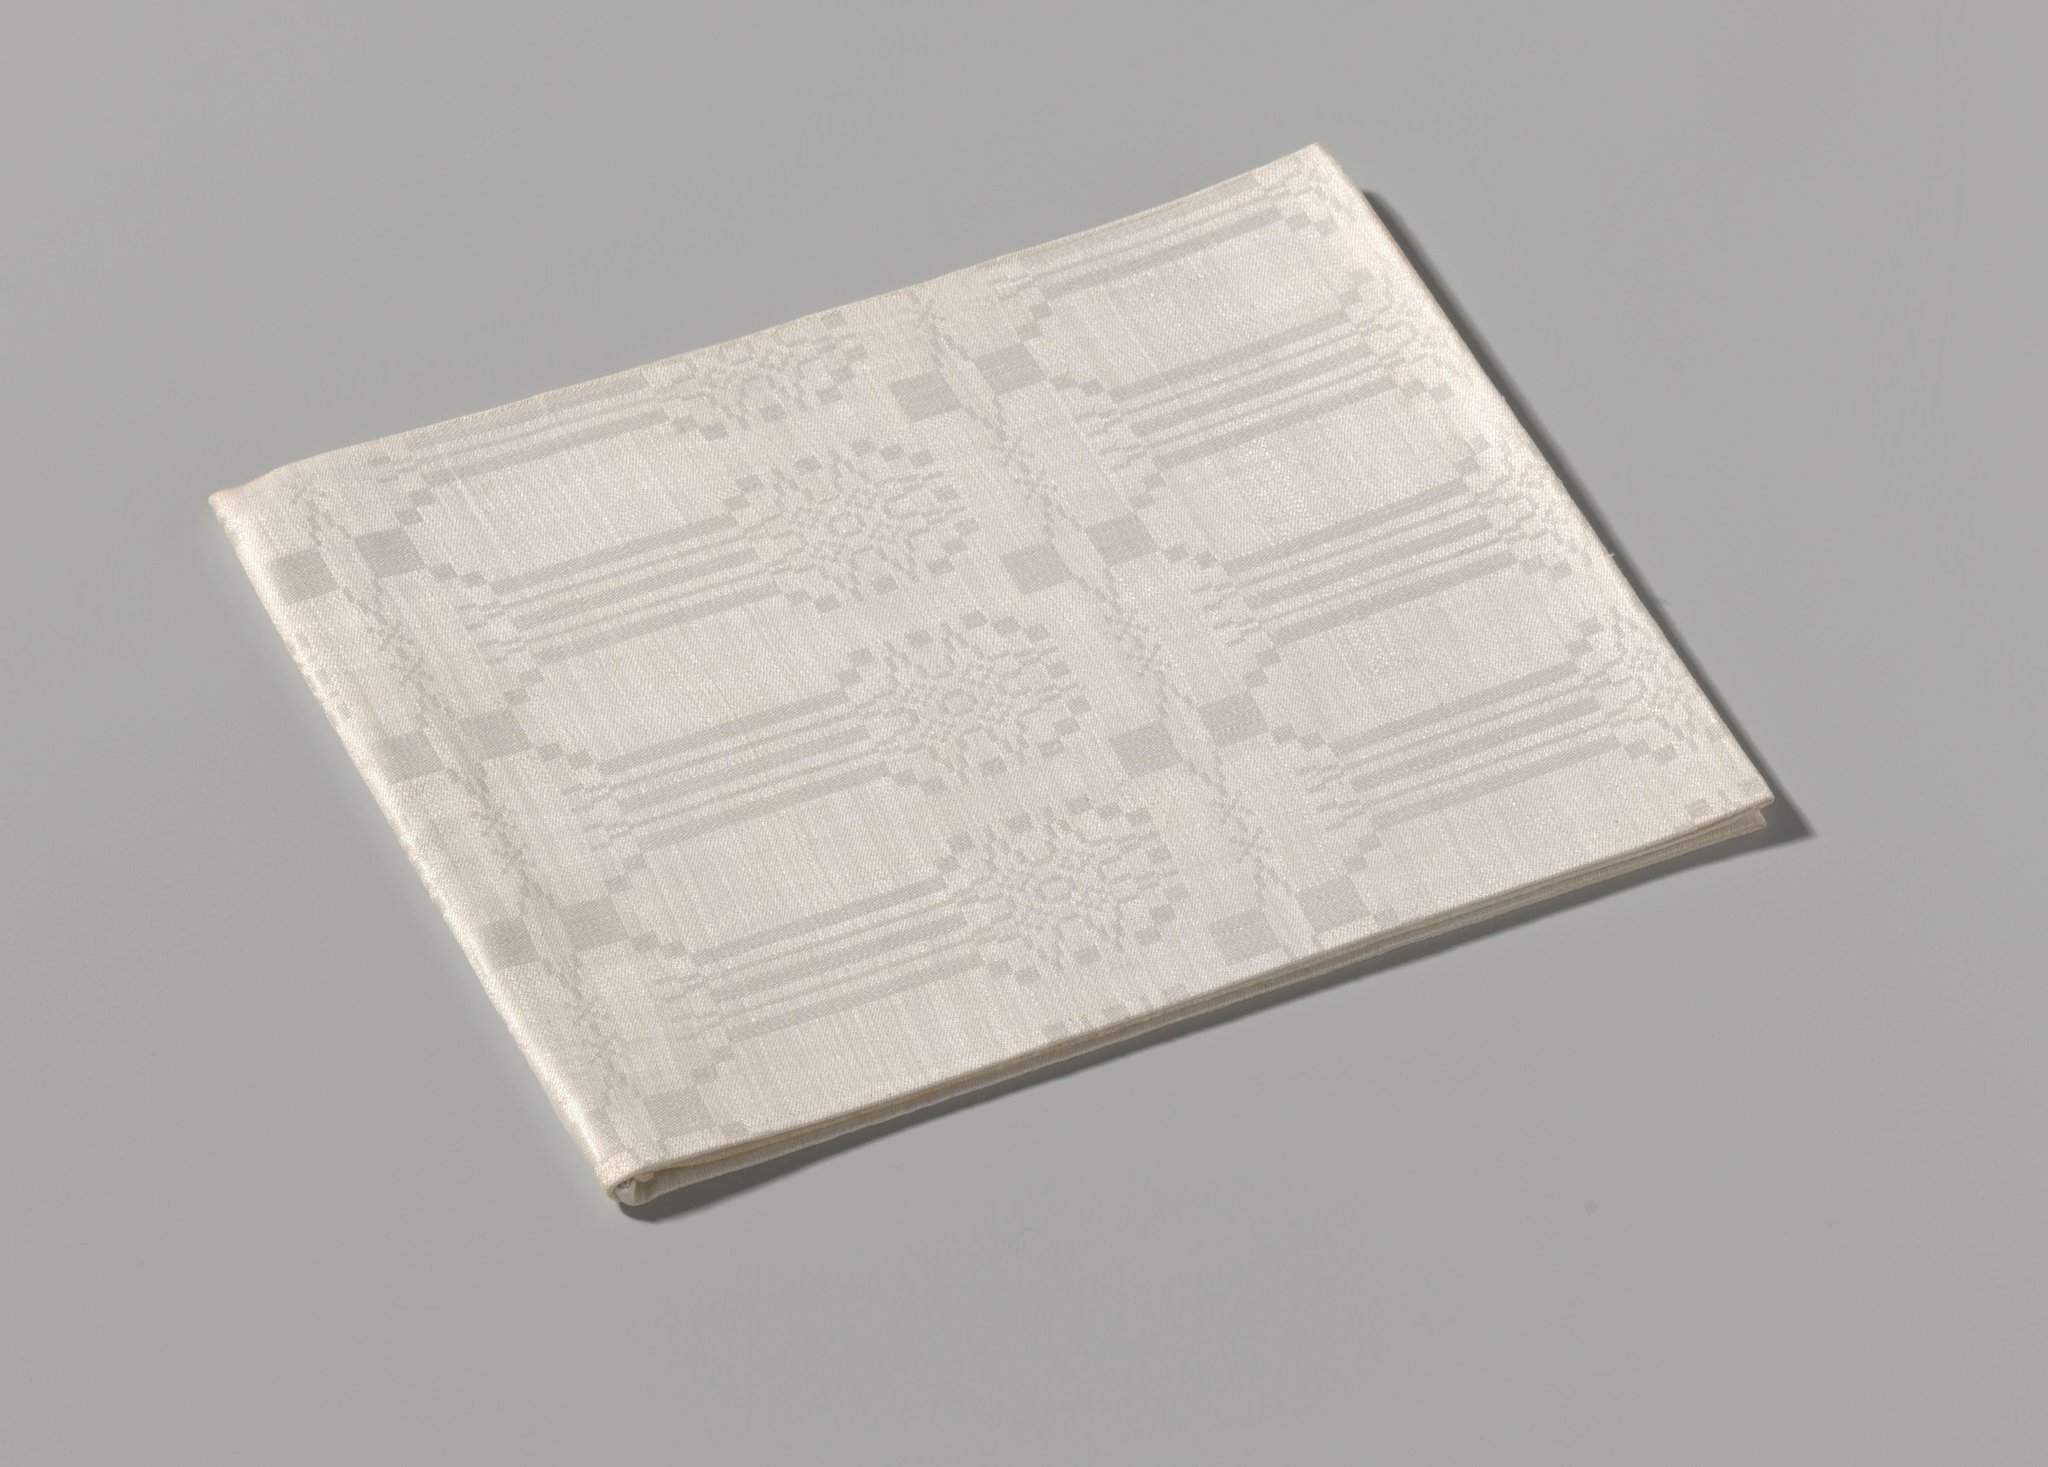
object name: napkin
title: Servet van linnen met pellenpatroon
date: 1734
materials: linen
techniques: peeled fabric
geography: northern netherlands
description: Servet van wit linnen met pellenpatroon "oranjeboom", merk WG 60 1734.